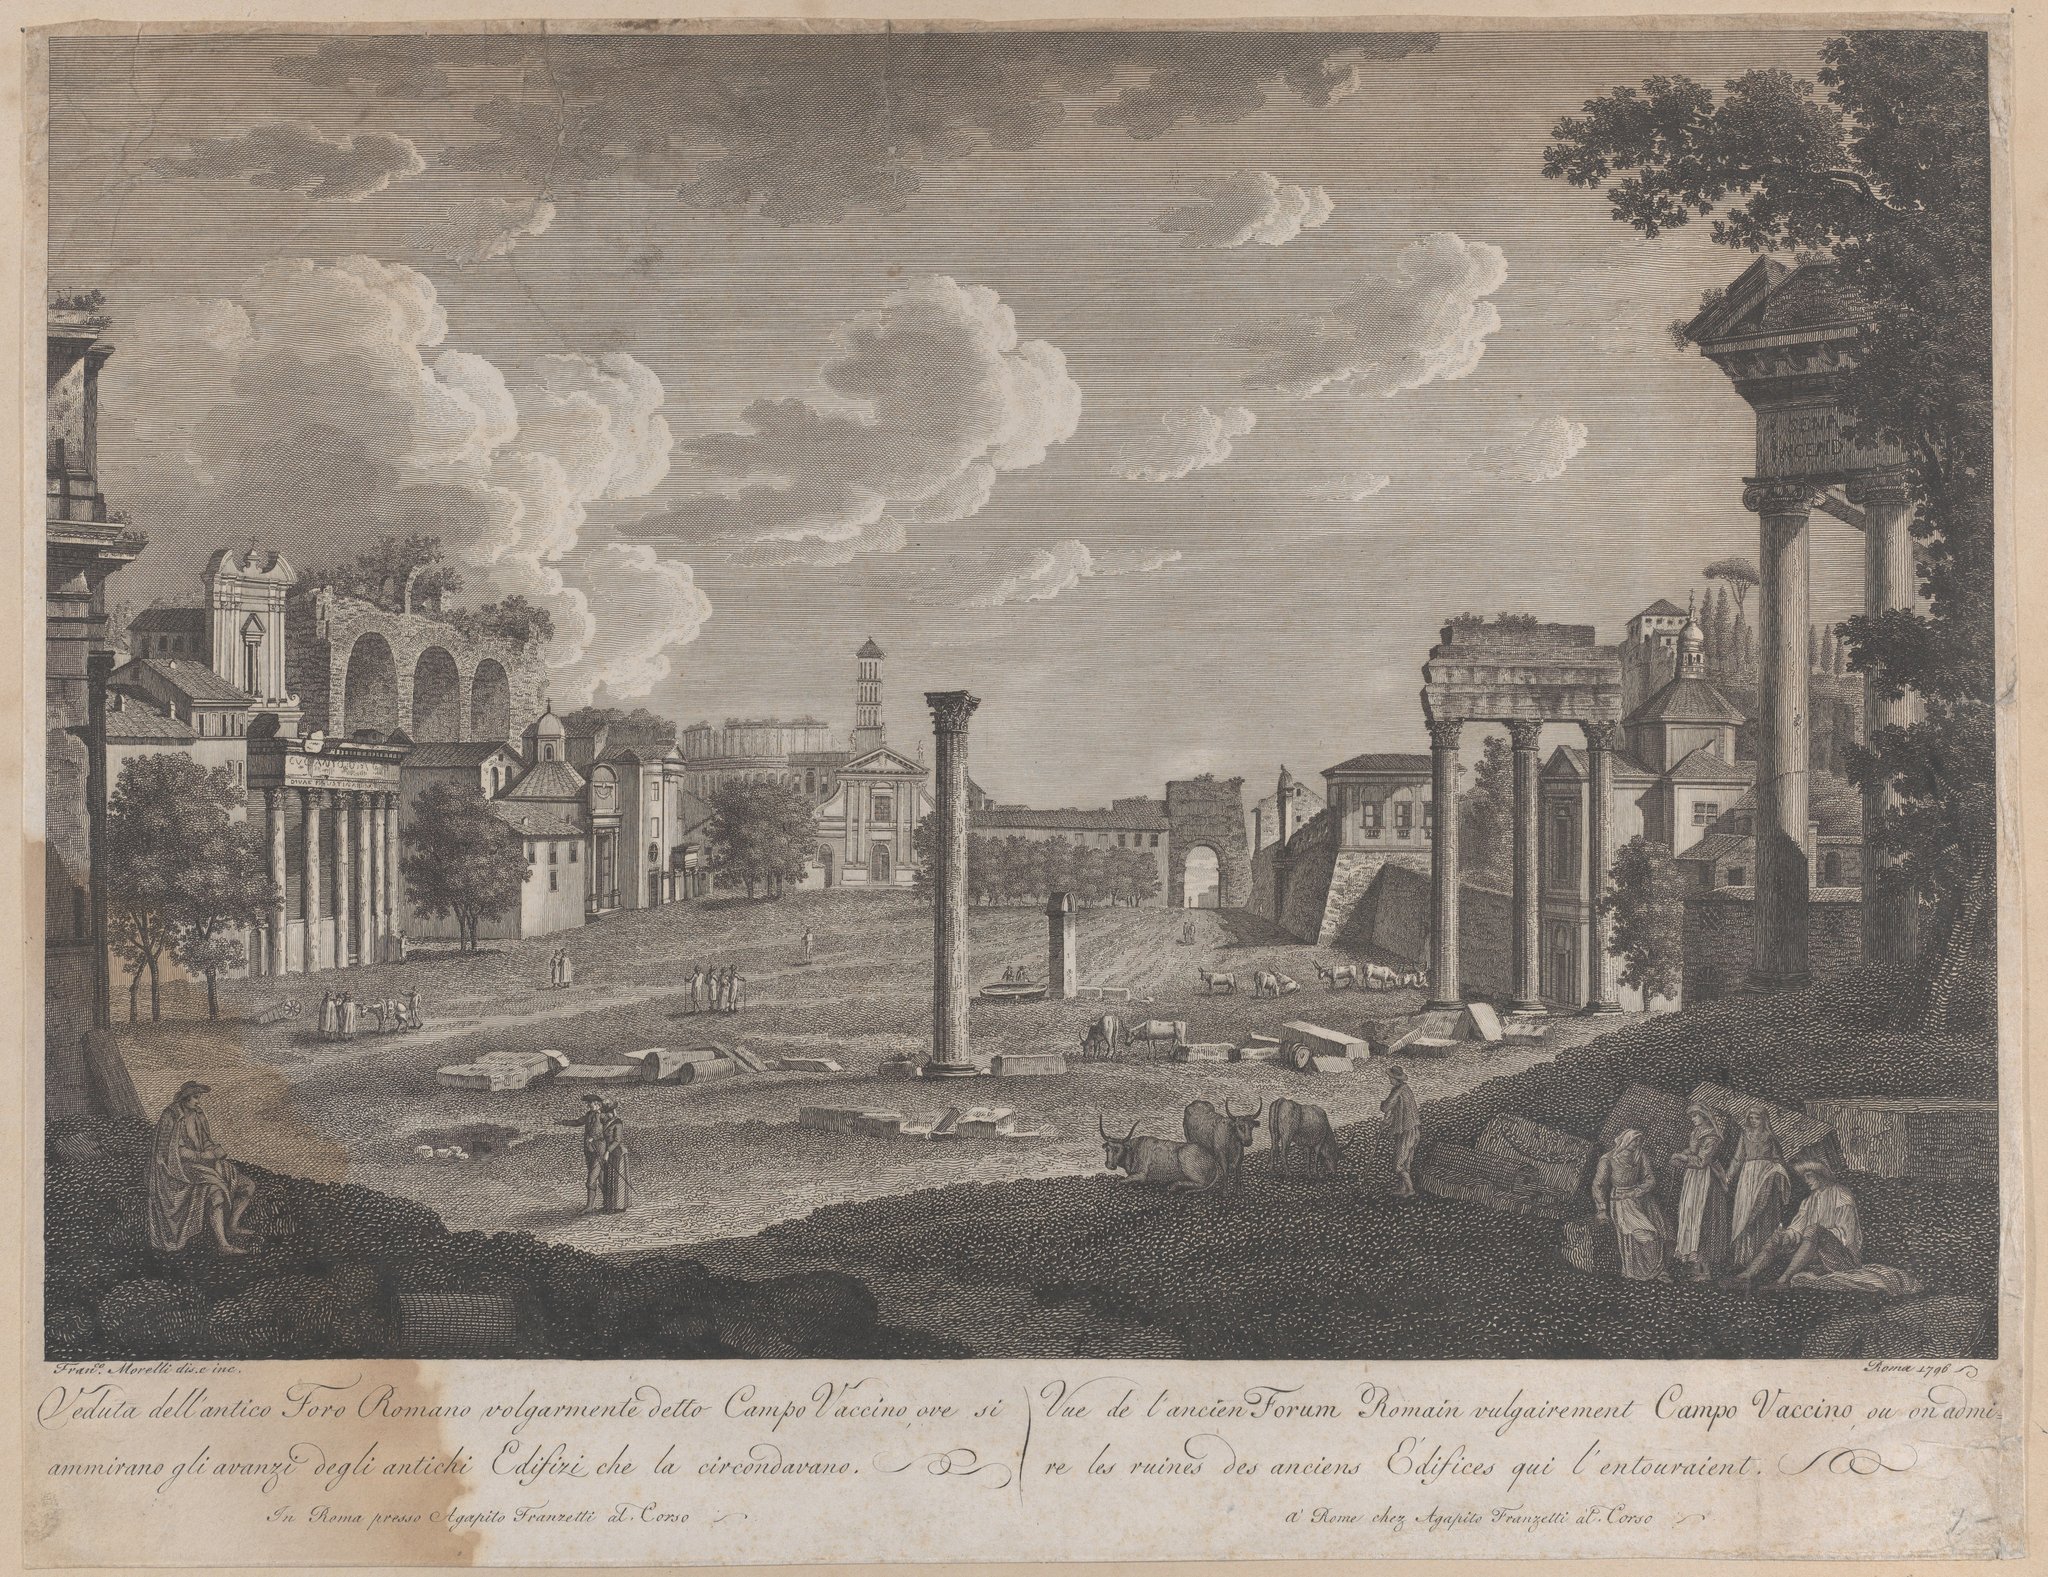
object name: print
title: View of the Campo Vaccino, with the Colosseum in the background and the ruins of the Temple of Castor and Pollux at right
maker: françois morel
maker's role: artist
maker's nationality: french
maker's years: 1768-1830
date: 1796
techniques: etching